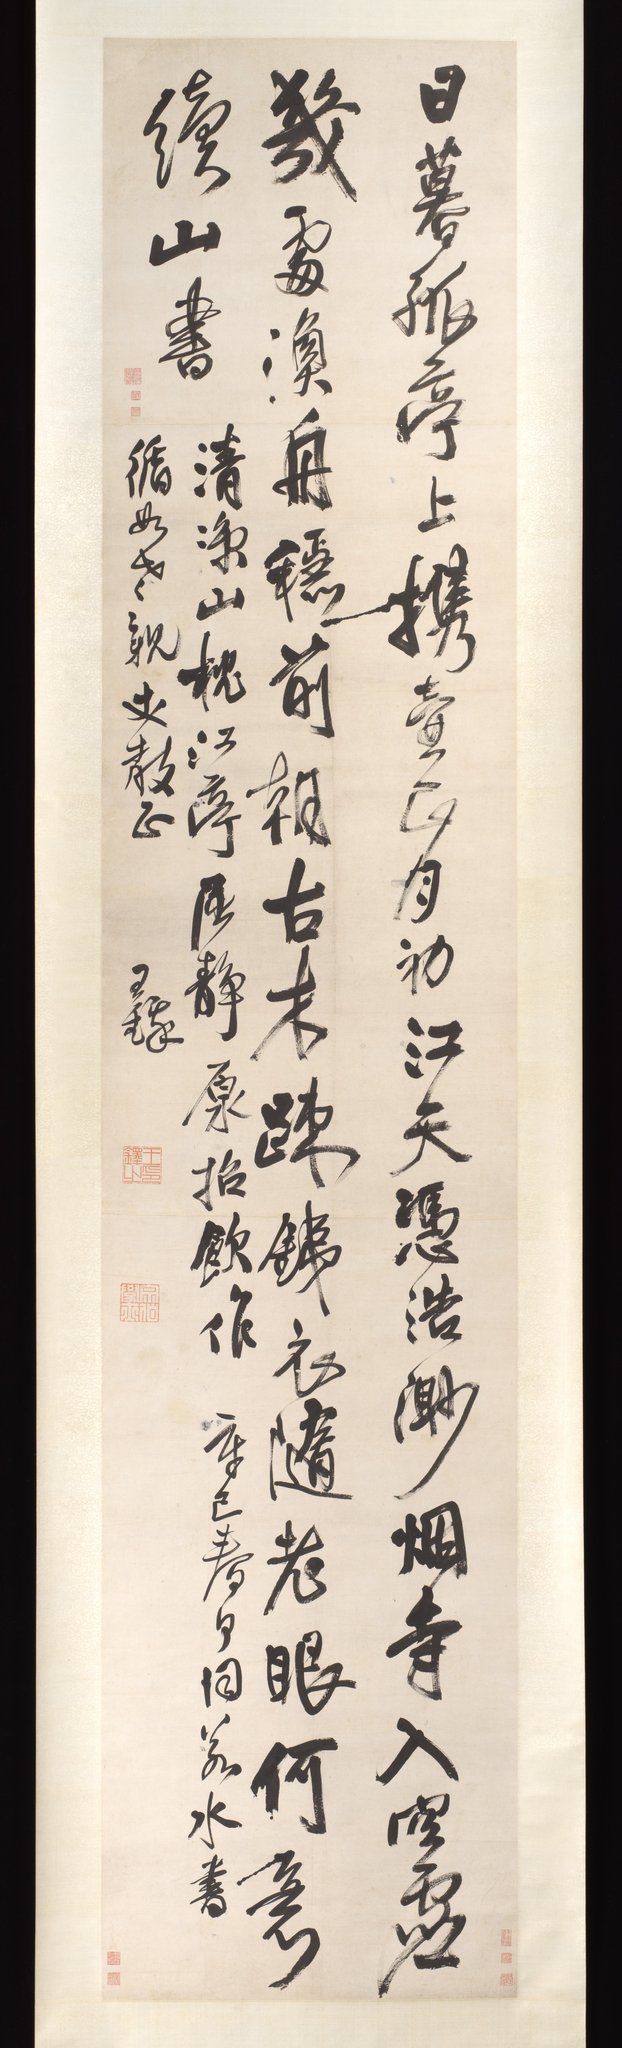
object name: hanging scroll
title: Poem on a Riverside Pavilion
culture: chinese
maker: wang duo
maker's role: artist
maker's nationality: chinese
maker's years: 1592-1652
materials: ink, paper